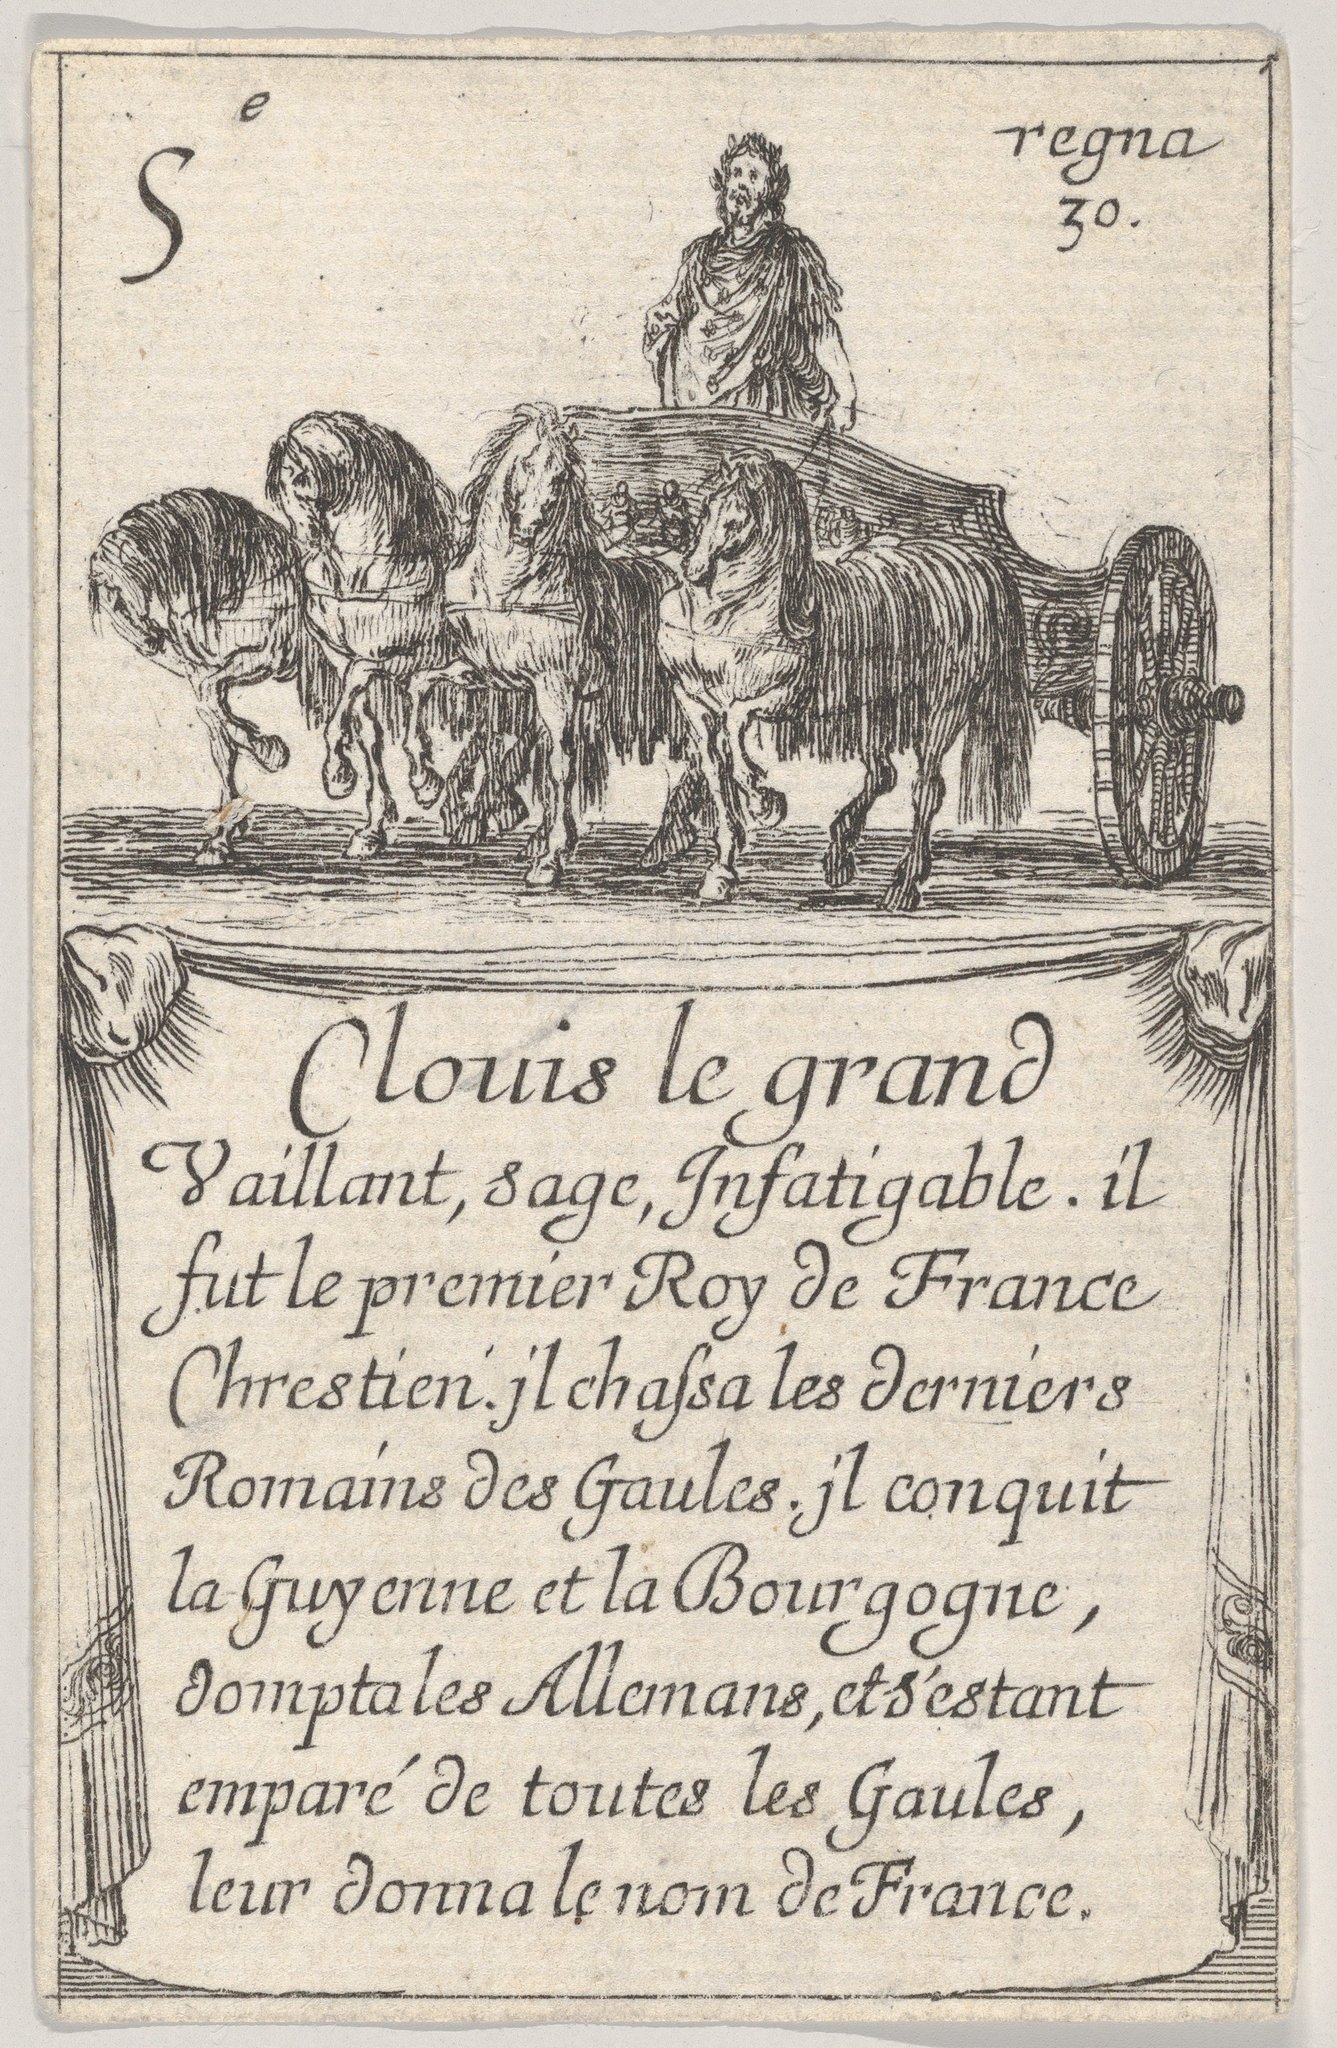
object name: print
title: Clovis le grand / Vaillant, sage..., from "Game of the Kings of France" (Jeu des Rois de France)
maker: stefano della bella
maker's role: artist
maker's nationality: italian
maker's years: 1610-1664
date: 1644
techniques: etching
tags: men,carriages